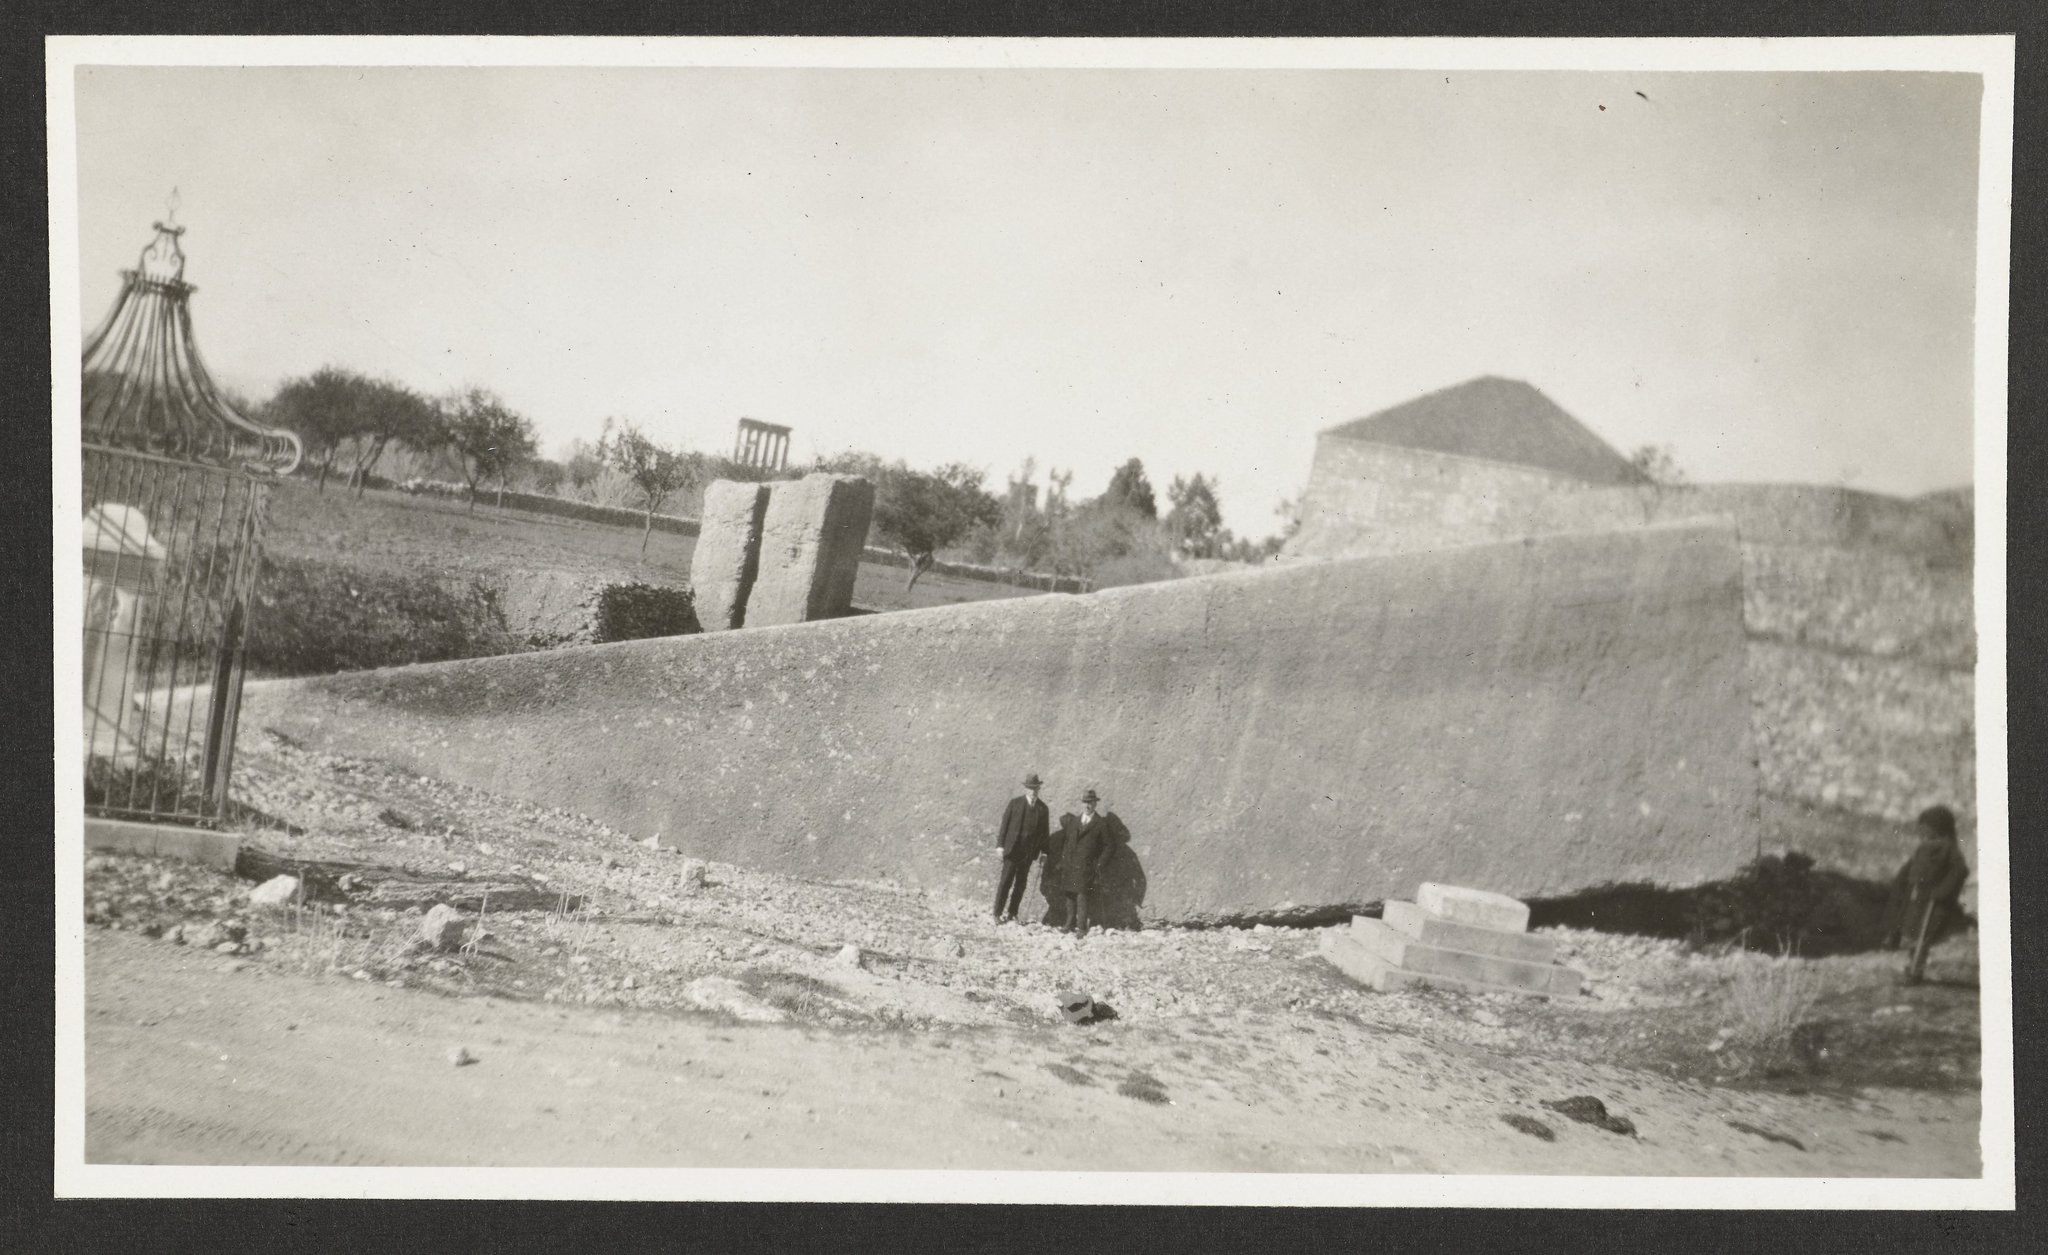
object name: photograph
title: Gehouwen steen in steengroeve nabij Baalbek, Libanon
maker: a.g.a. van eelde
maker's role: engineer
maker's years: 1862-1950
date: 1925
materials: cardboard, paper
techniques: gelatin silver print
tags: libanon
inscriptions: number: ‘2.’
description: Gehouwen kalksteen van ongeveer 1.100.000 kg met de volgende afmetingen: 21,5 x 4,5 x 4 meter. Drie stenen van deze afmetingen zijn verwerkt in de muur die het grondvalk van de tempel van Jupiter steunt. Voor de steen staan twee Westerse mannen.